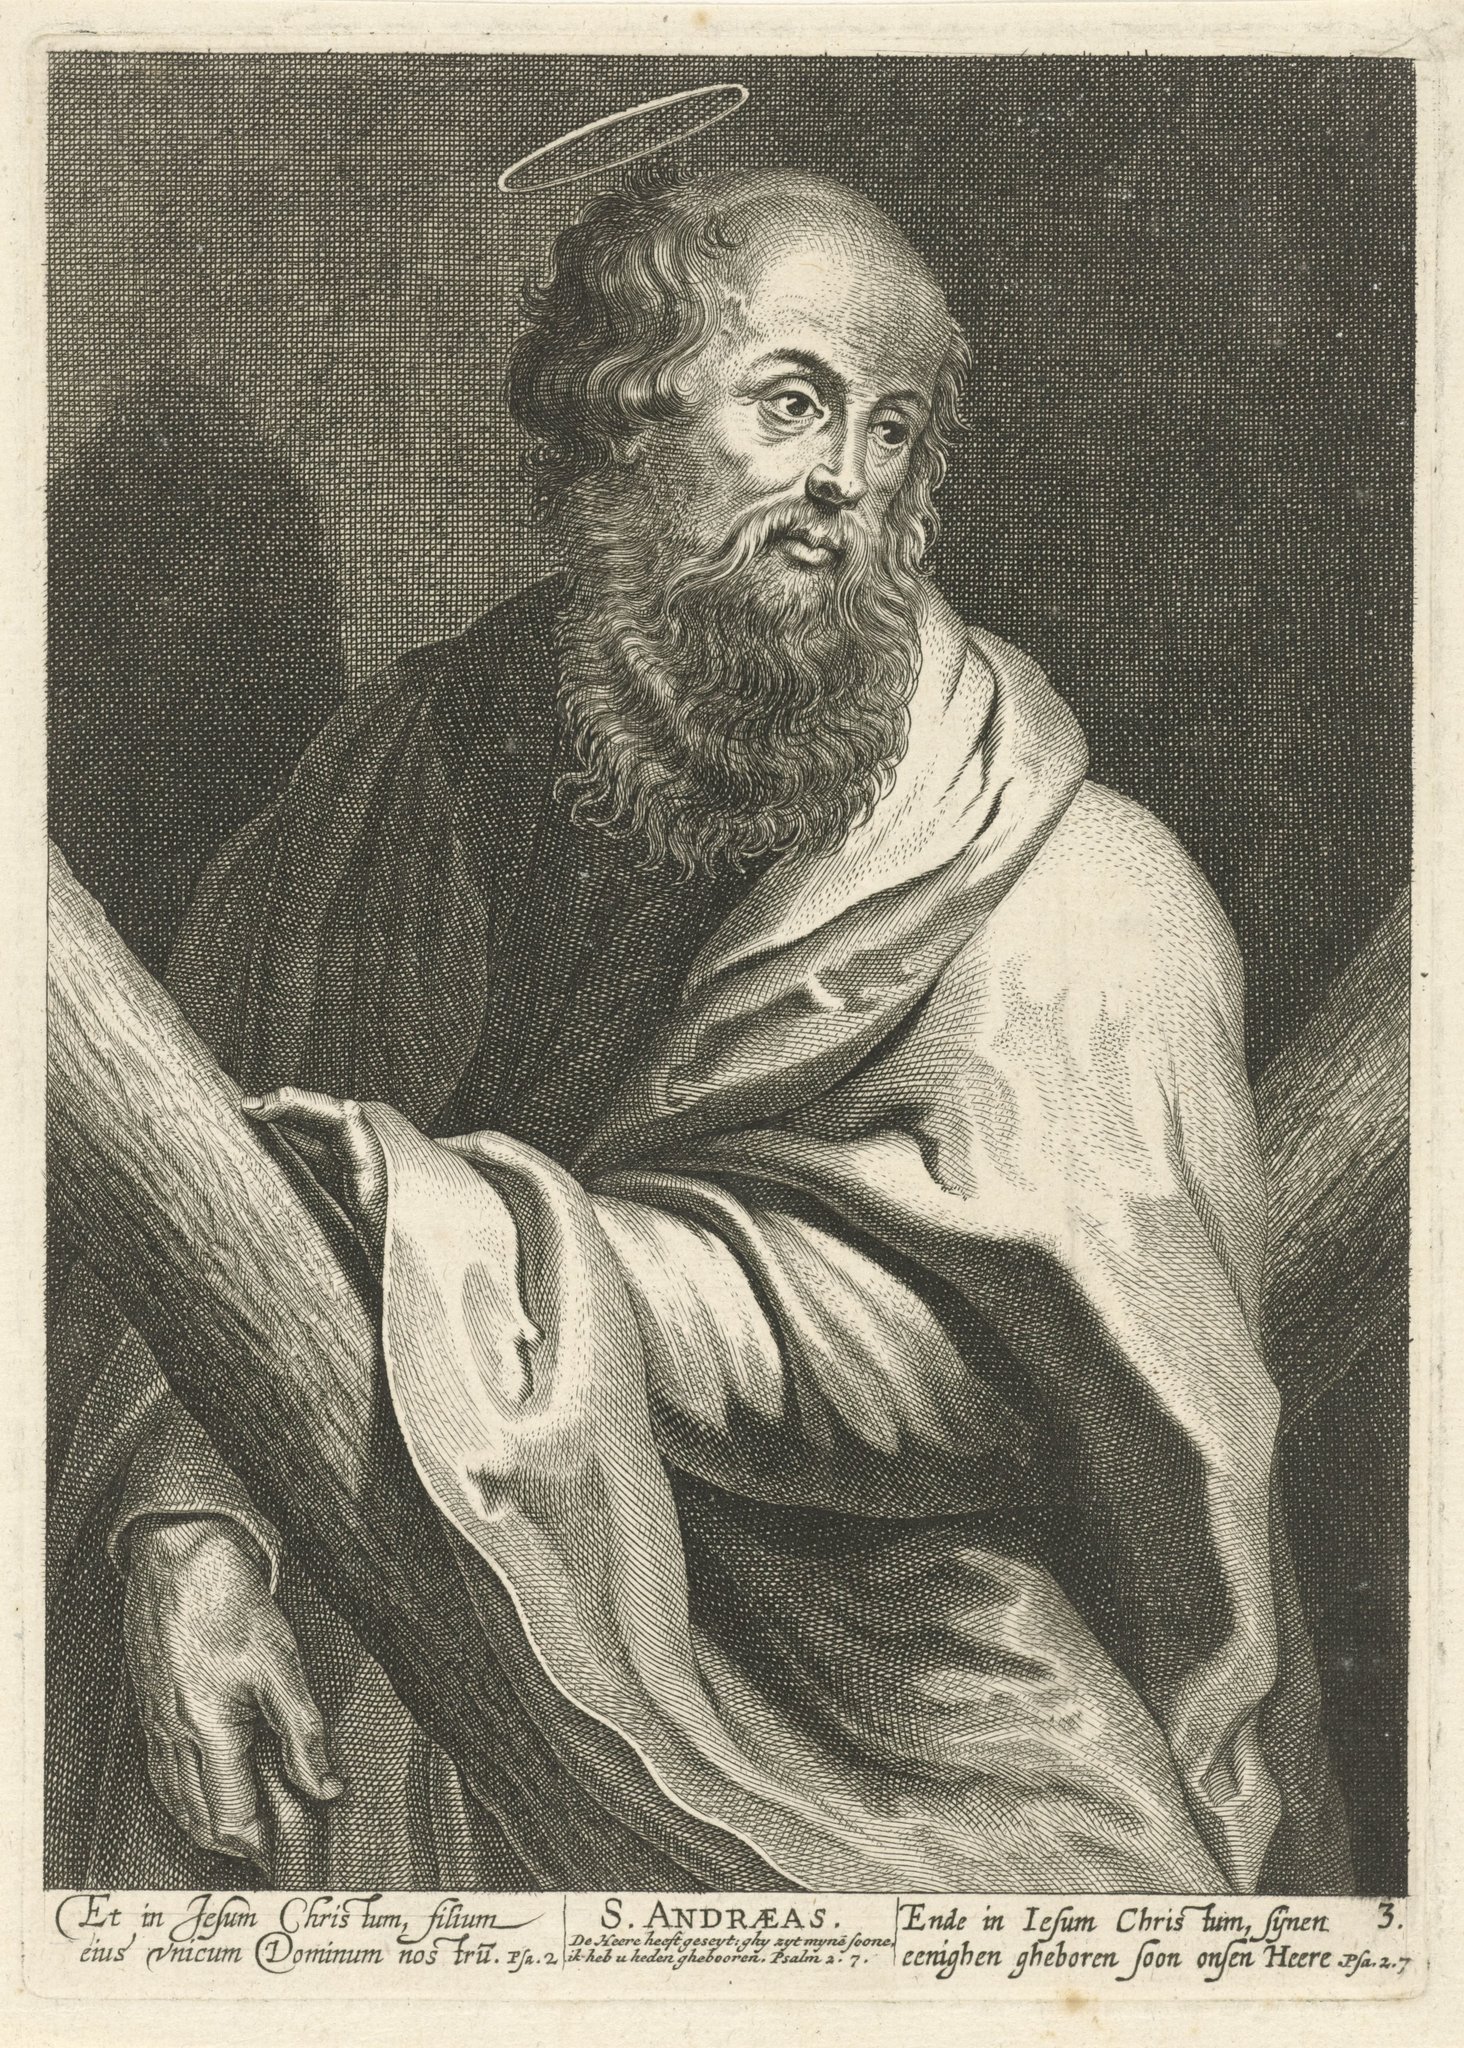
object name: print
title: Christus en dertien apostelen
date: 1630-1706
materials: paper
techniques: engraving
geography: amsterdam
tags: the apostle andrew; possible attributes: book, x-shaped cross, fish, fishing-net, rope, scroll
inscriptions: collector's mark: Lugt 240